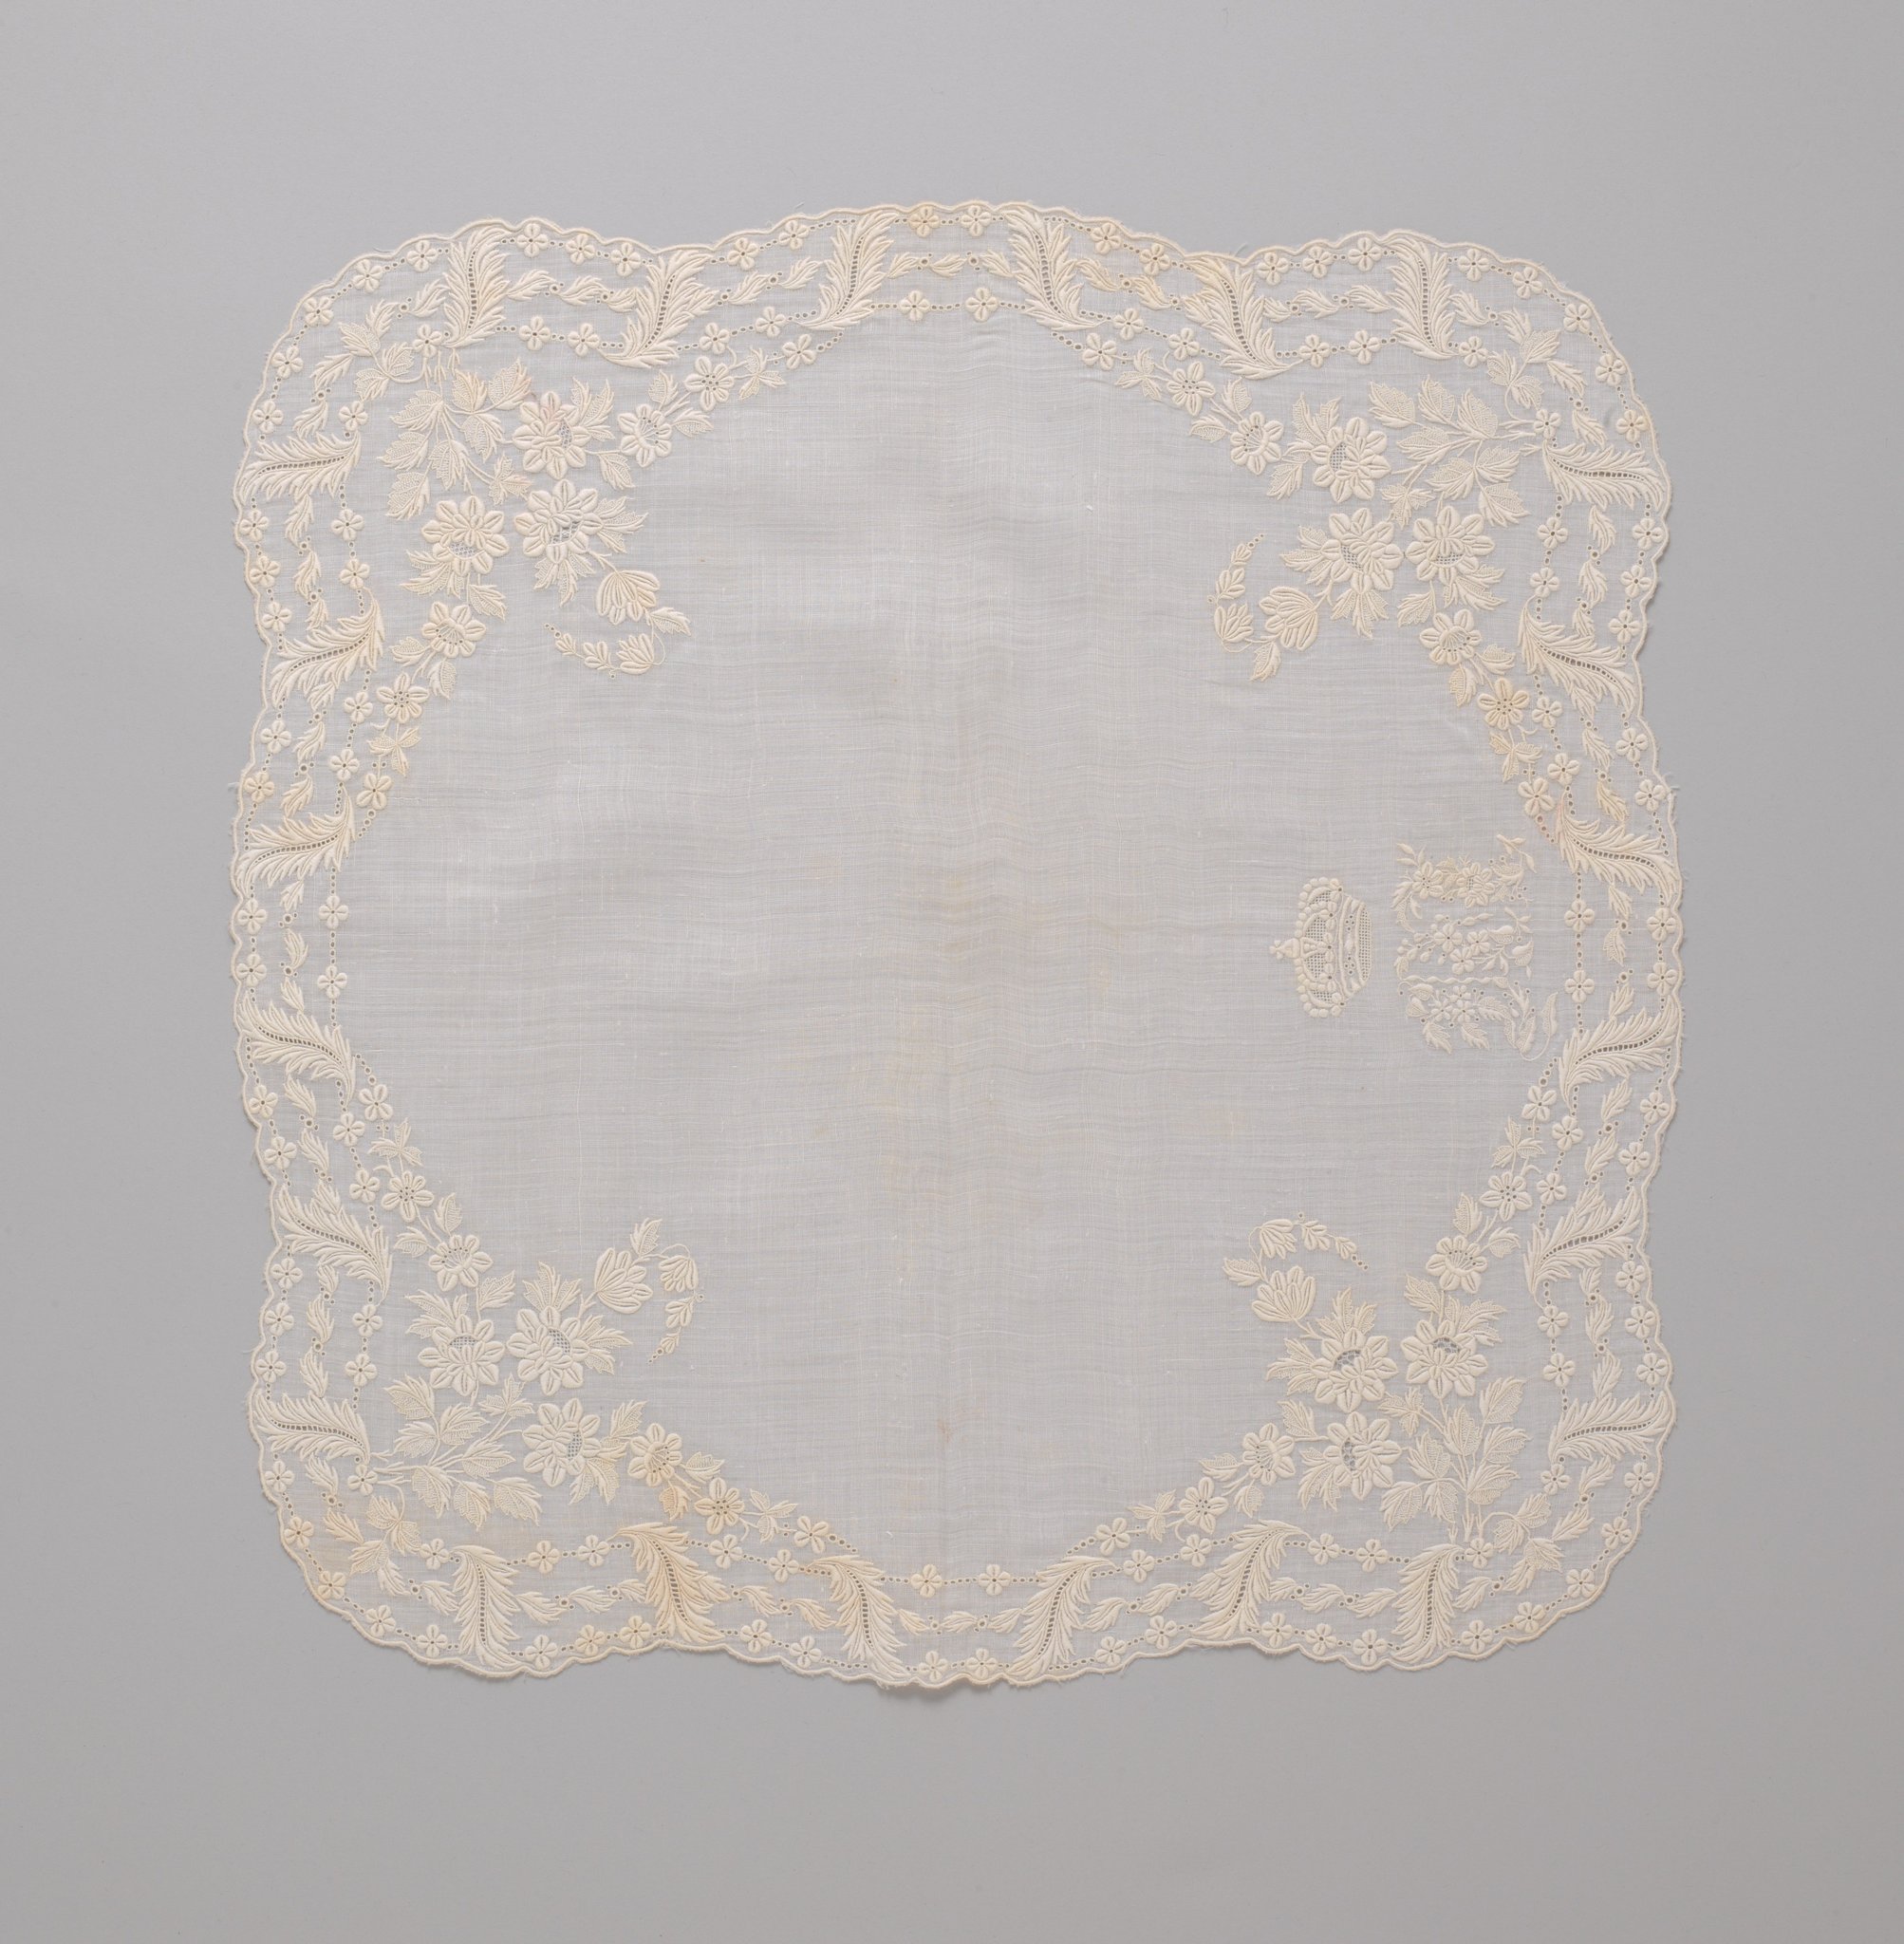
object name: handkerchief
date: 1840-1880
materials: linen, silk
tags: flowers